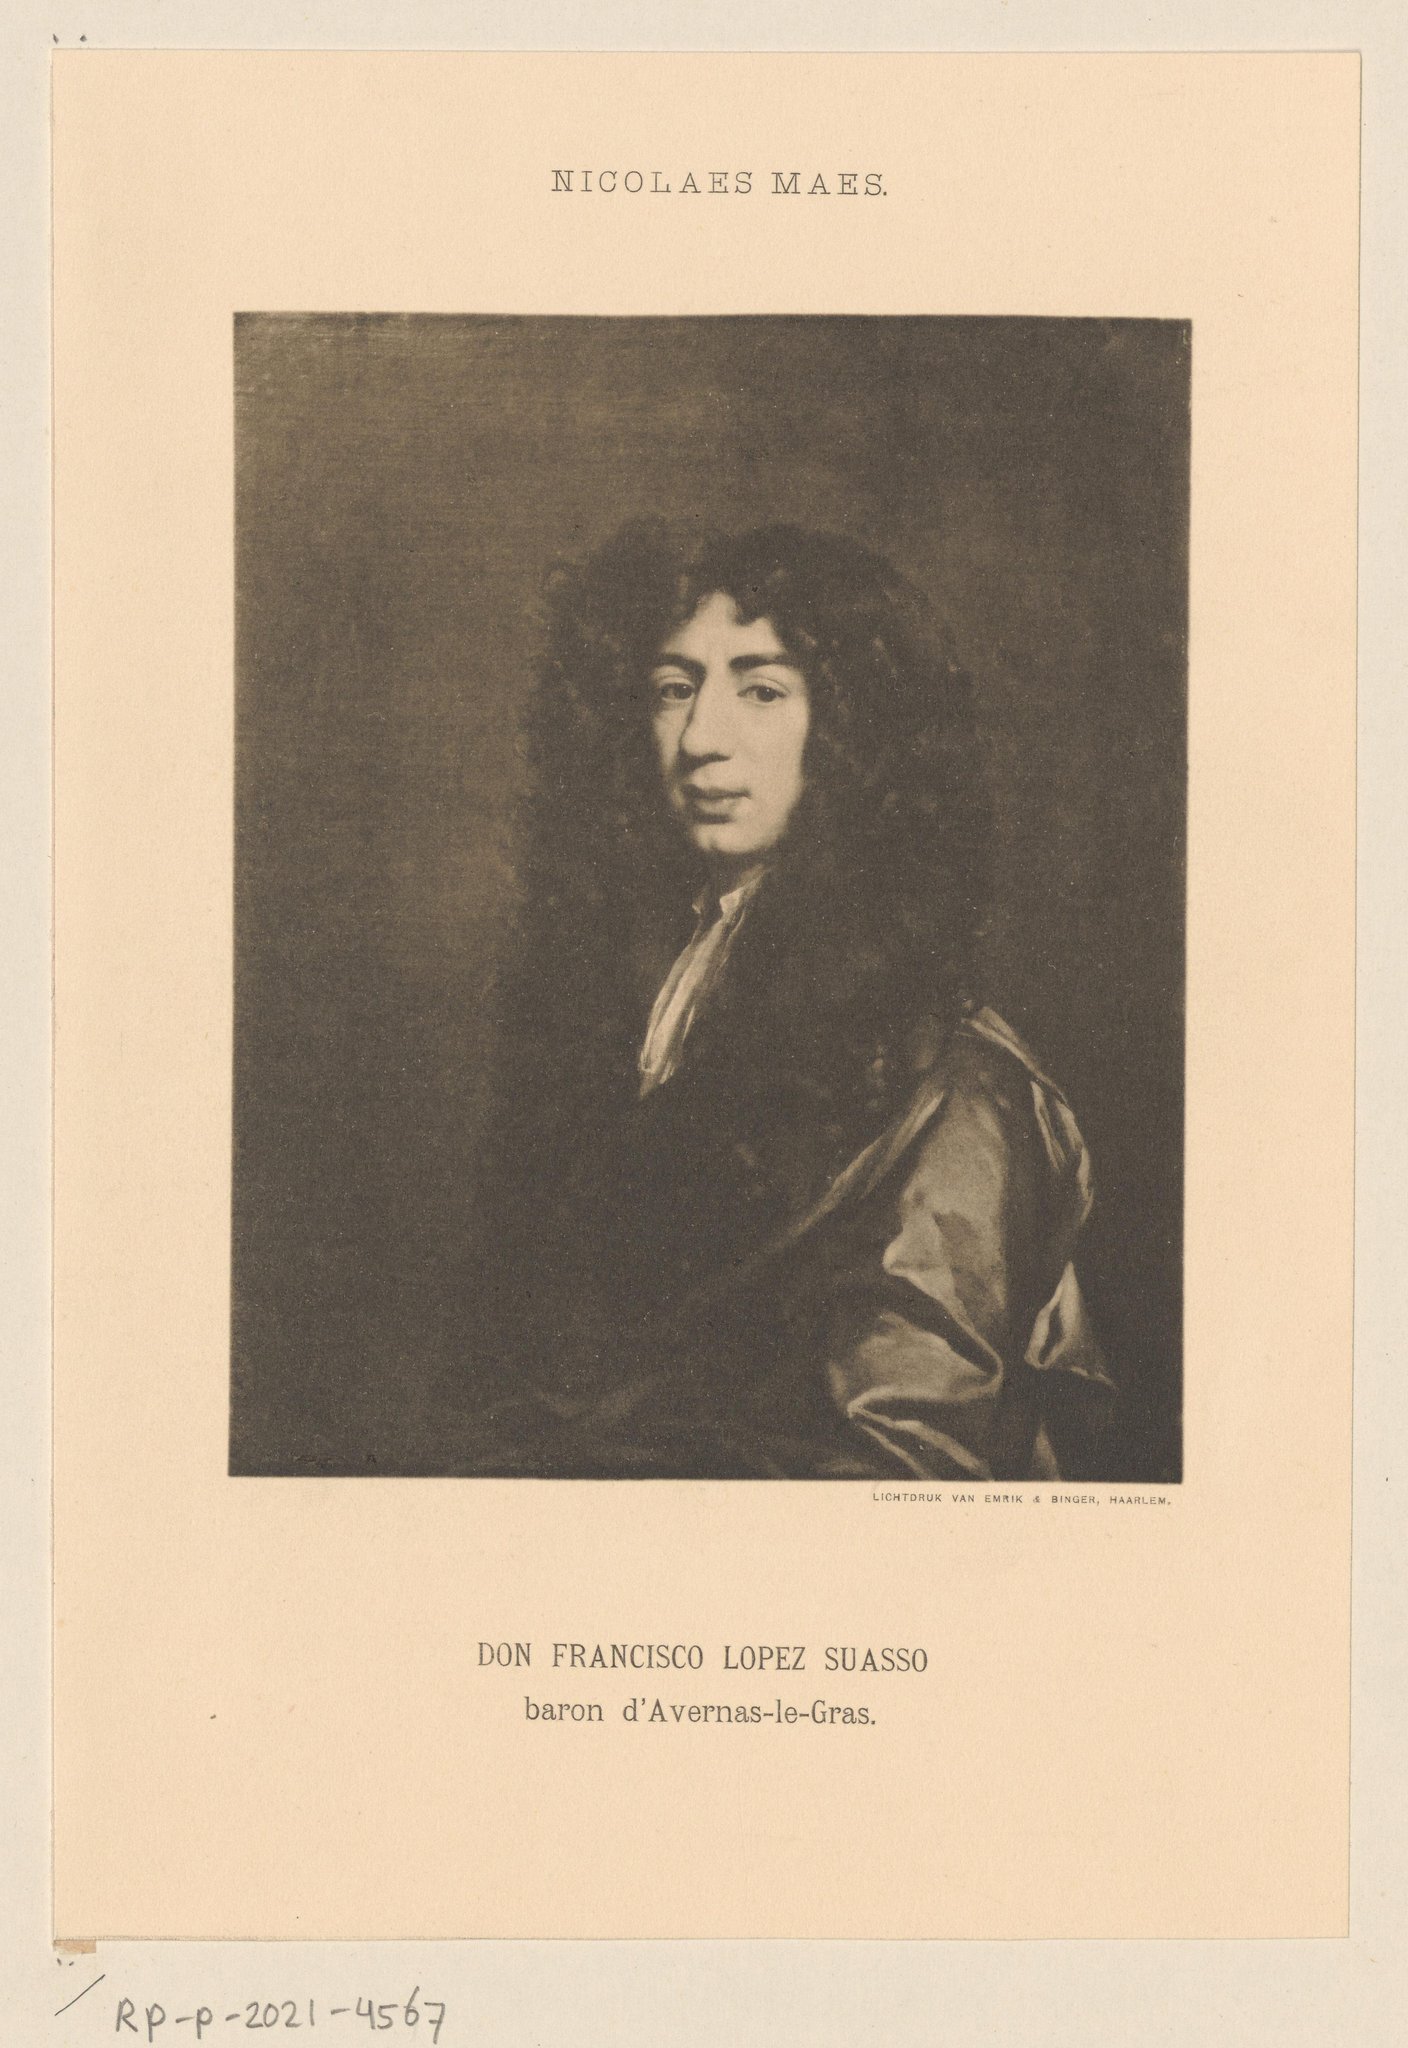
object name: photomechanical print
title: Portret van Francisco Lopes Suasso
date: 1870-1927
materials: paper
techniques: photograph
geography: haarlem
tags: amsterdam, historical persons